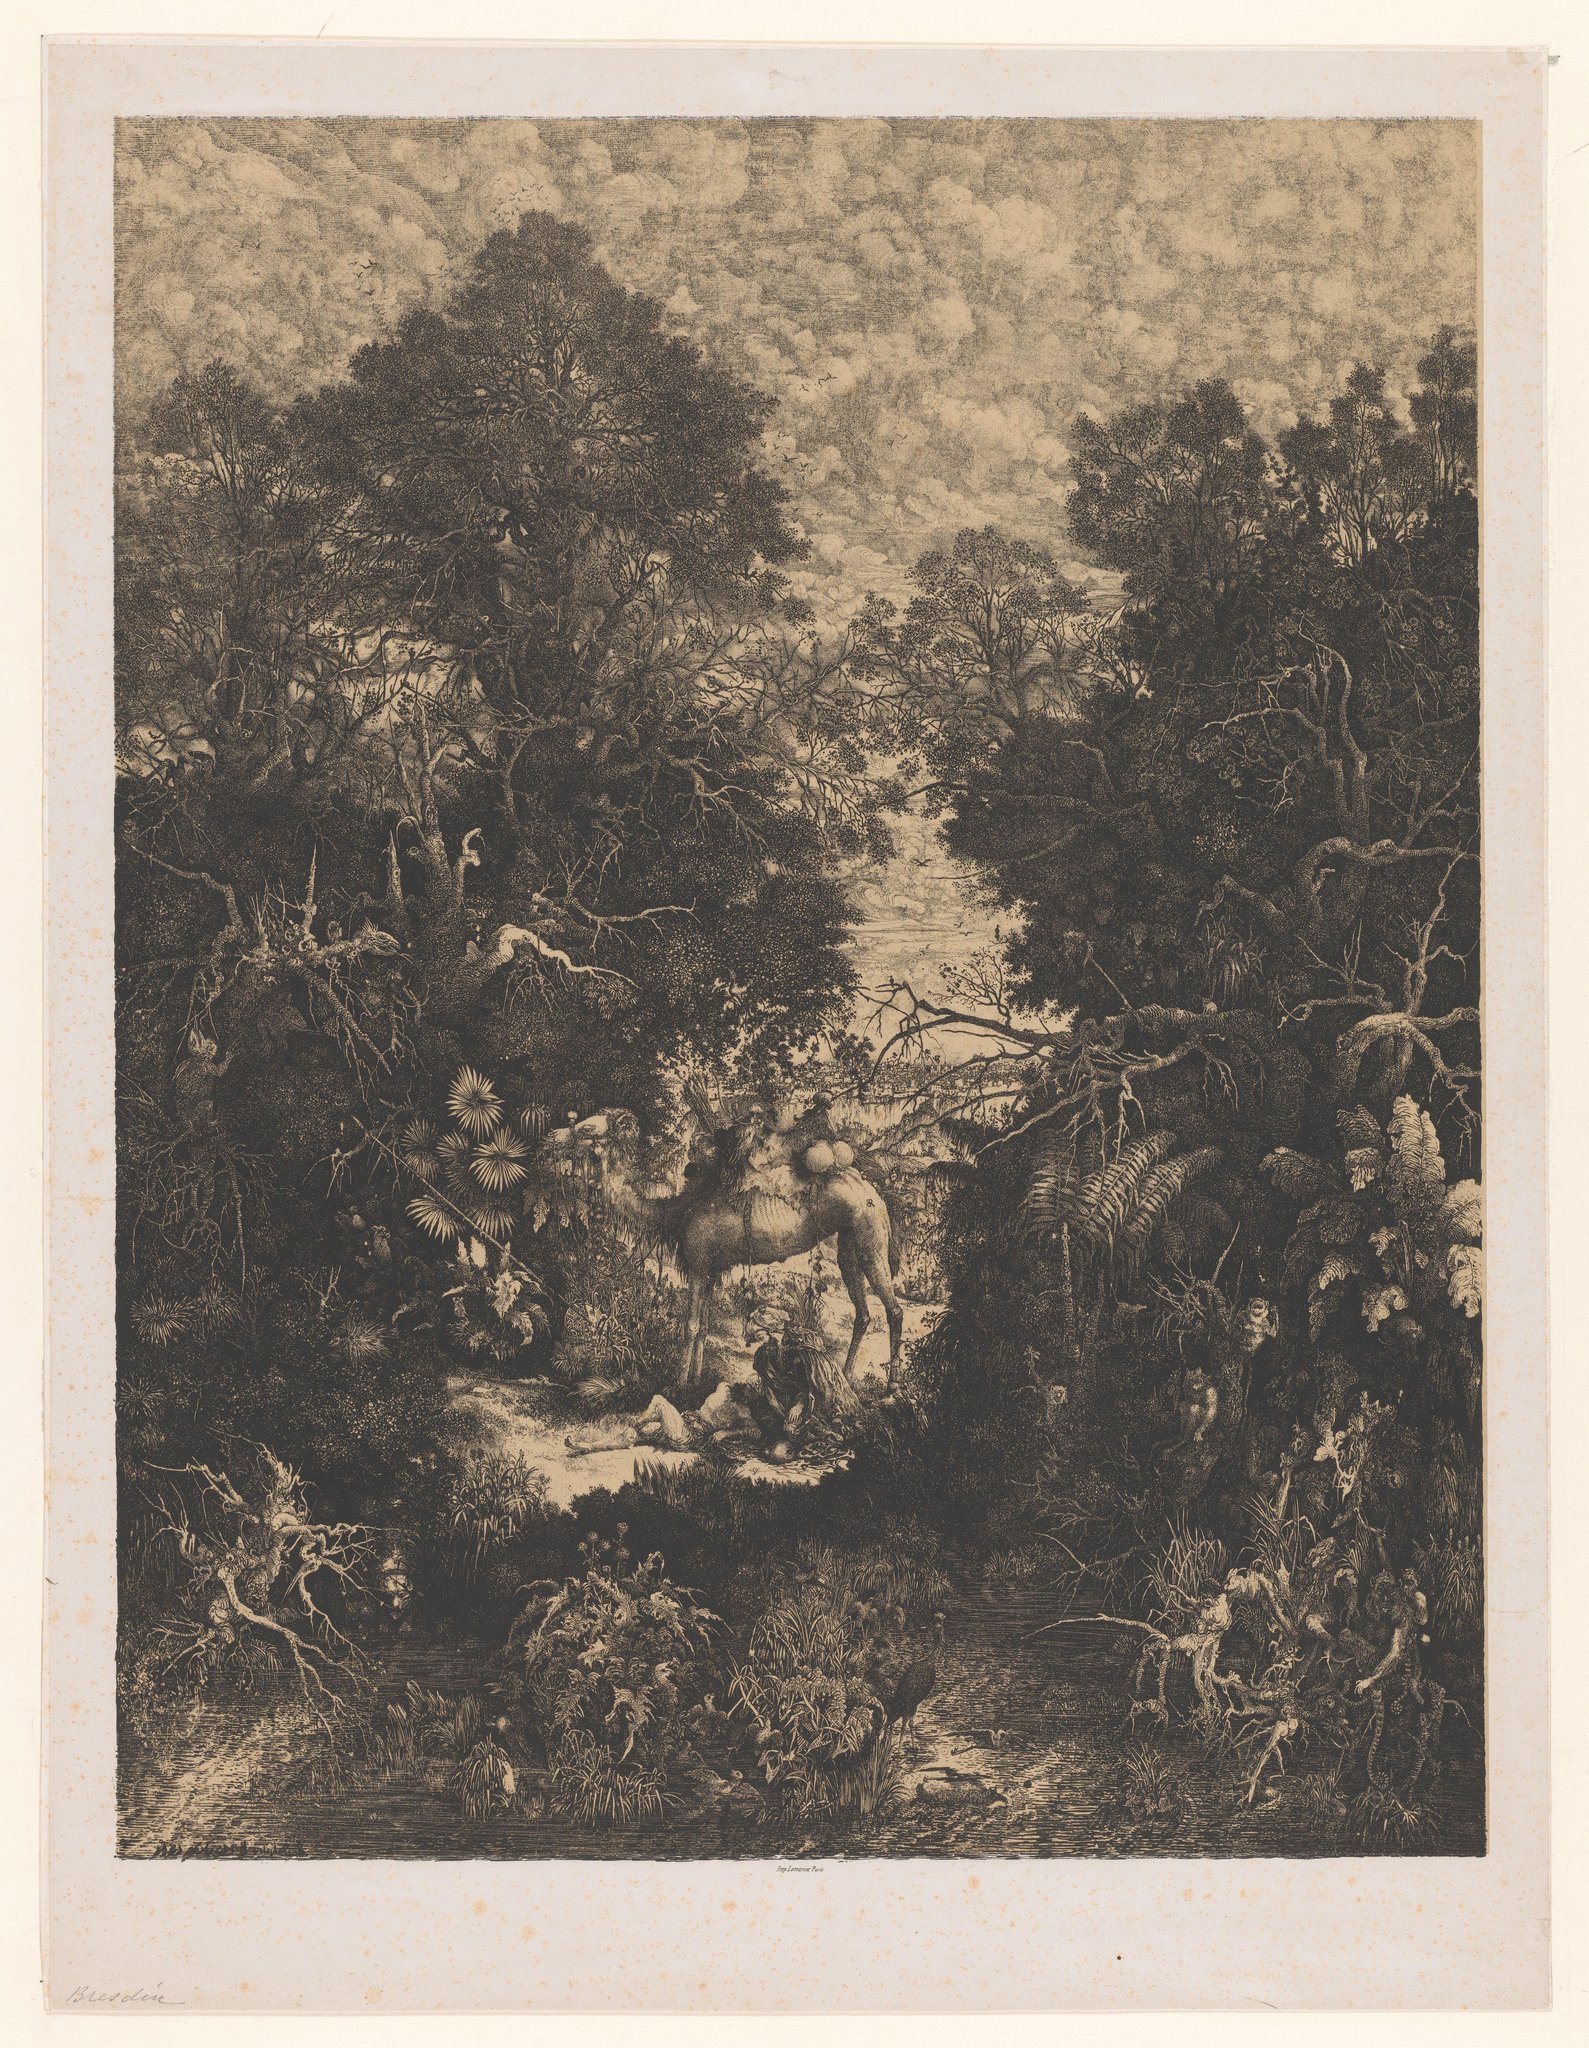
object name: print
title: Le Bon Samaritain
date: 1861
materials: paper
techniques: pen lithography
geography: paris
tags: jungle (+ landscape (in the non-temperate zone) with figures, staffage), a samaritan tending the wounds of the traveller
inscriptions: collector's mark: Lugt 2228a